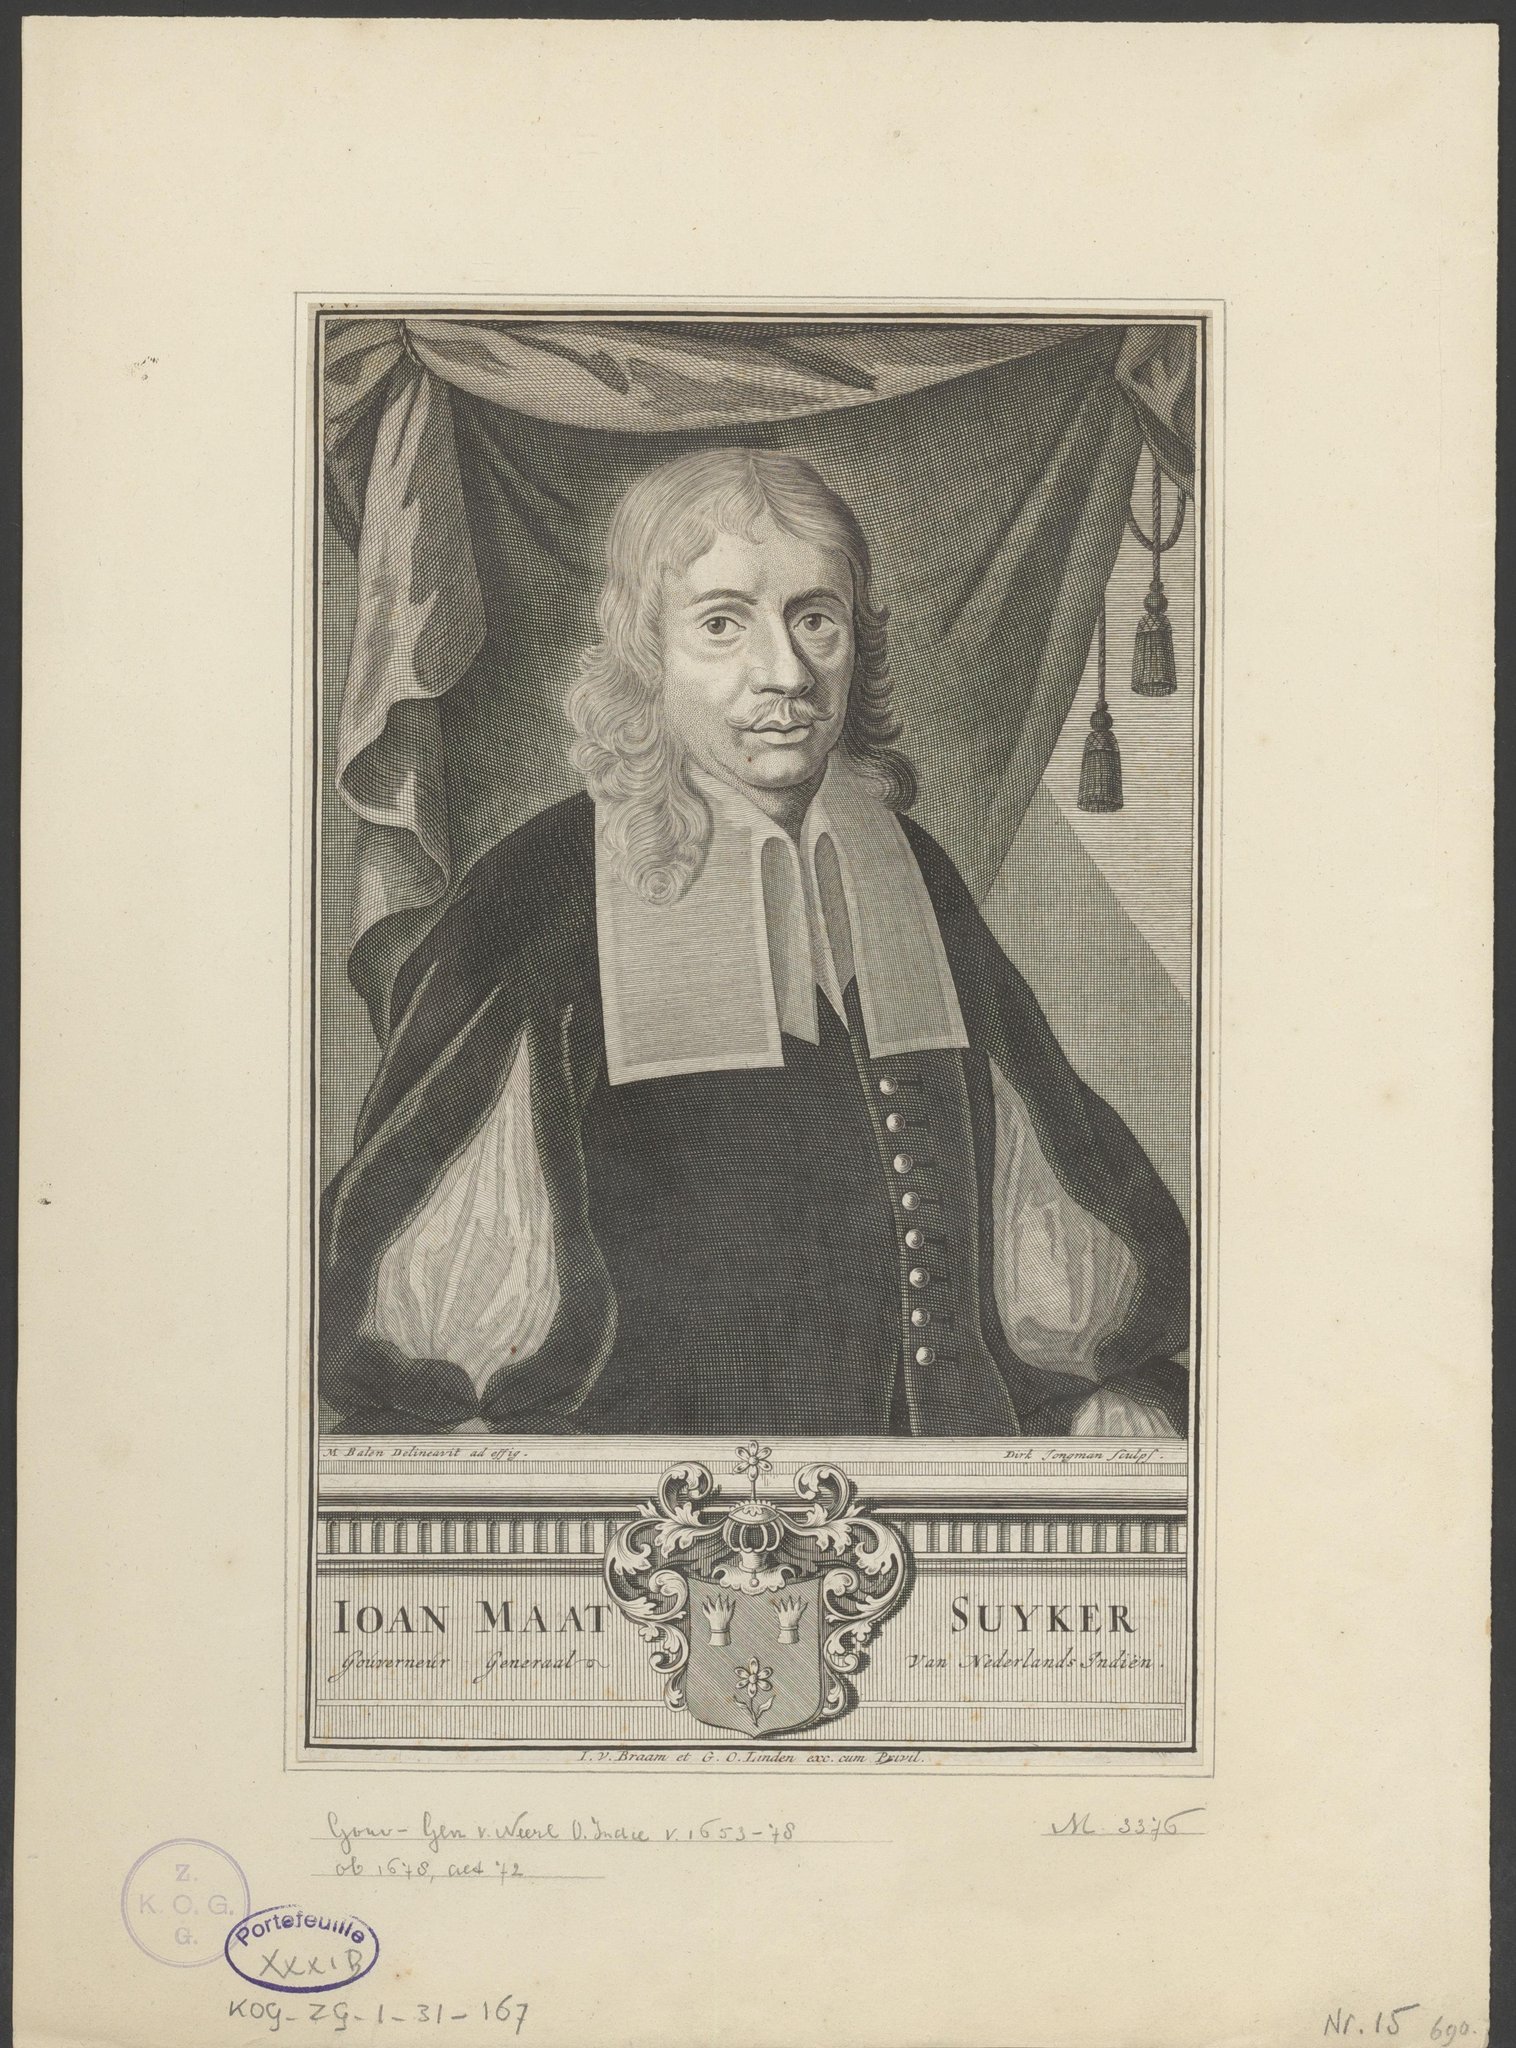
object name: print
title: Portret van Joan Maetsuyker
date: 1709-1726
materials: paper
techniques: engraving, etching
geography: dordrecht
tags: batavia, historical persons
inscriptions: collector's mark: Lugt 1641, stamp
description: Portret van de gouverneur-generaal Johannes Maetsuyker, ten halven lijve. Hij staat voor een gordijn. Op de plint staan zijn wapenschild en naam en functie in het Nederlands. Onderwerpsrubrieken binnen de Atlas Zeden en Gewoonten: Portretten, Portretten van bijzondere personen.